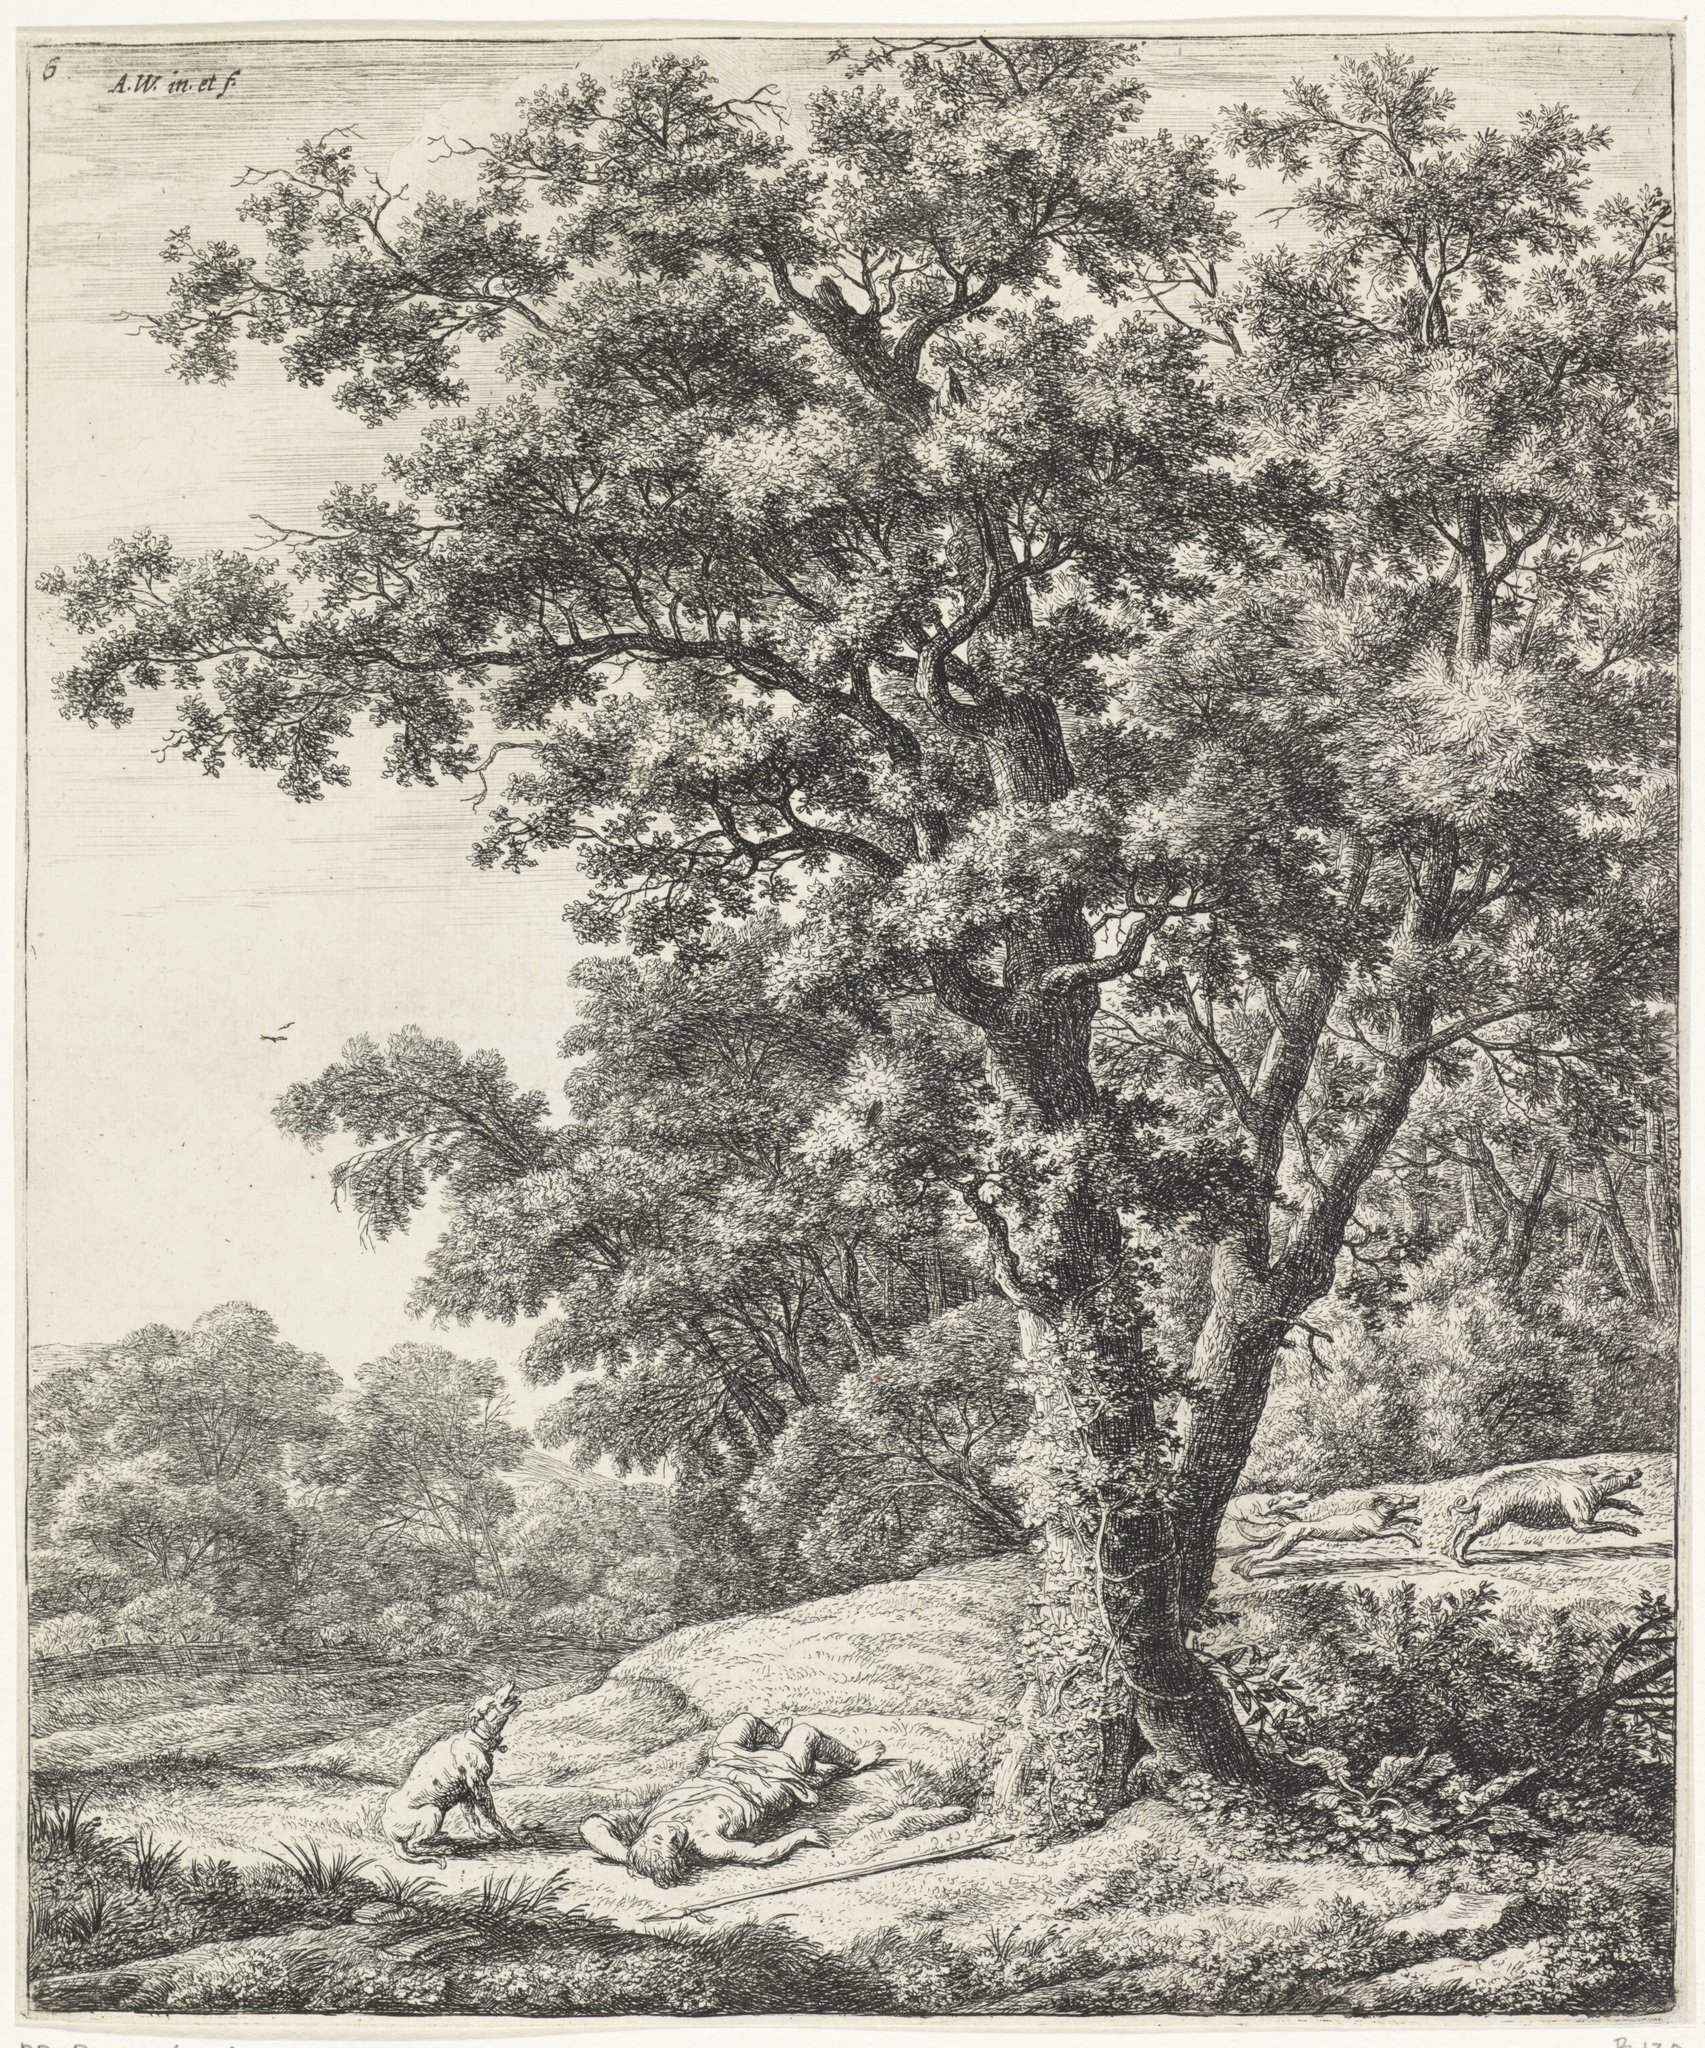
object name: print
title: Landschappen met scènes uit Ovidius' Metamorfosen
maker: anthonie waterloo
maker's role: draughtsman, painter, print maker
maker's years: 1609-1690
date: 1630-1663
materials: paper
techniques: etching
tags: forest, wood, death of adonis: he is killed by a boar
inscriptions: collector's mark: Lugt 240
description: Adonis ligt dood op de grond en naast hem zit een hond. Bij zijn lichaam ligt zijn speer. Rechts rent een wild zwijn het bos in, gevolgd door een hond.